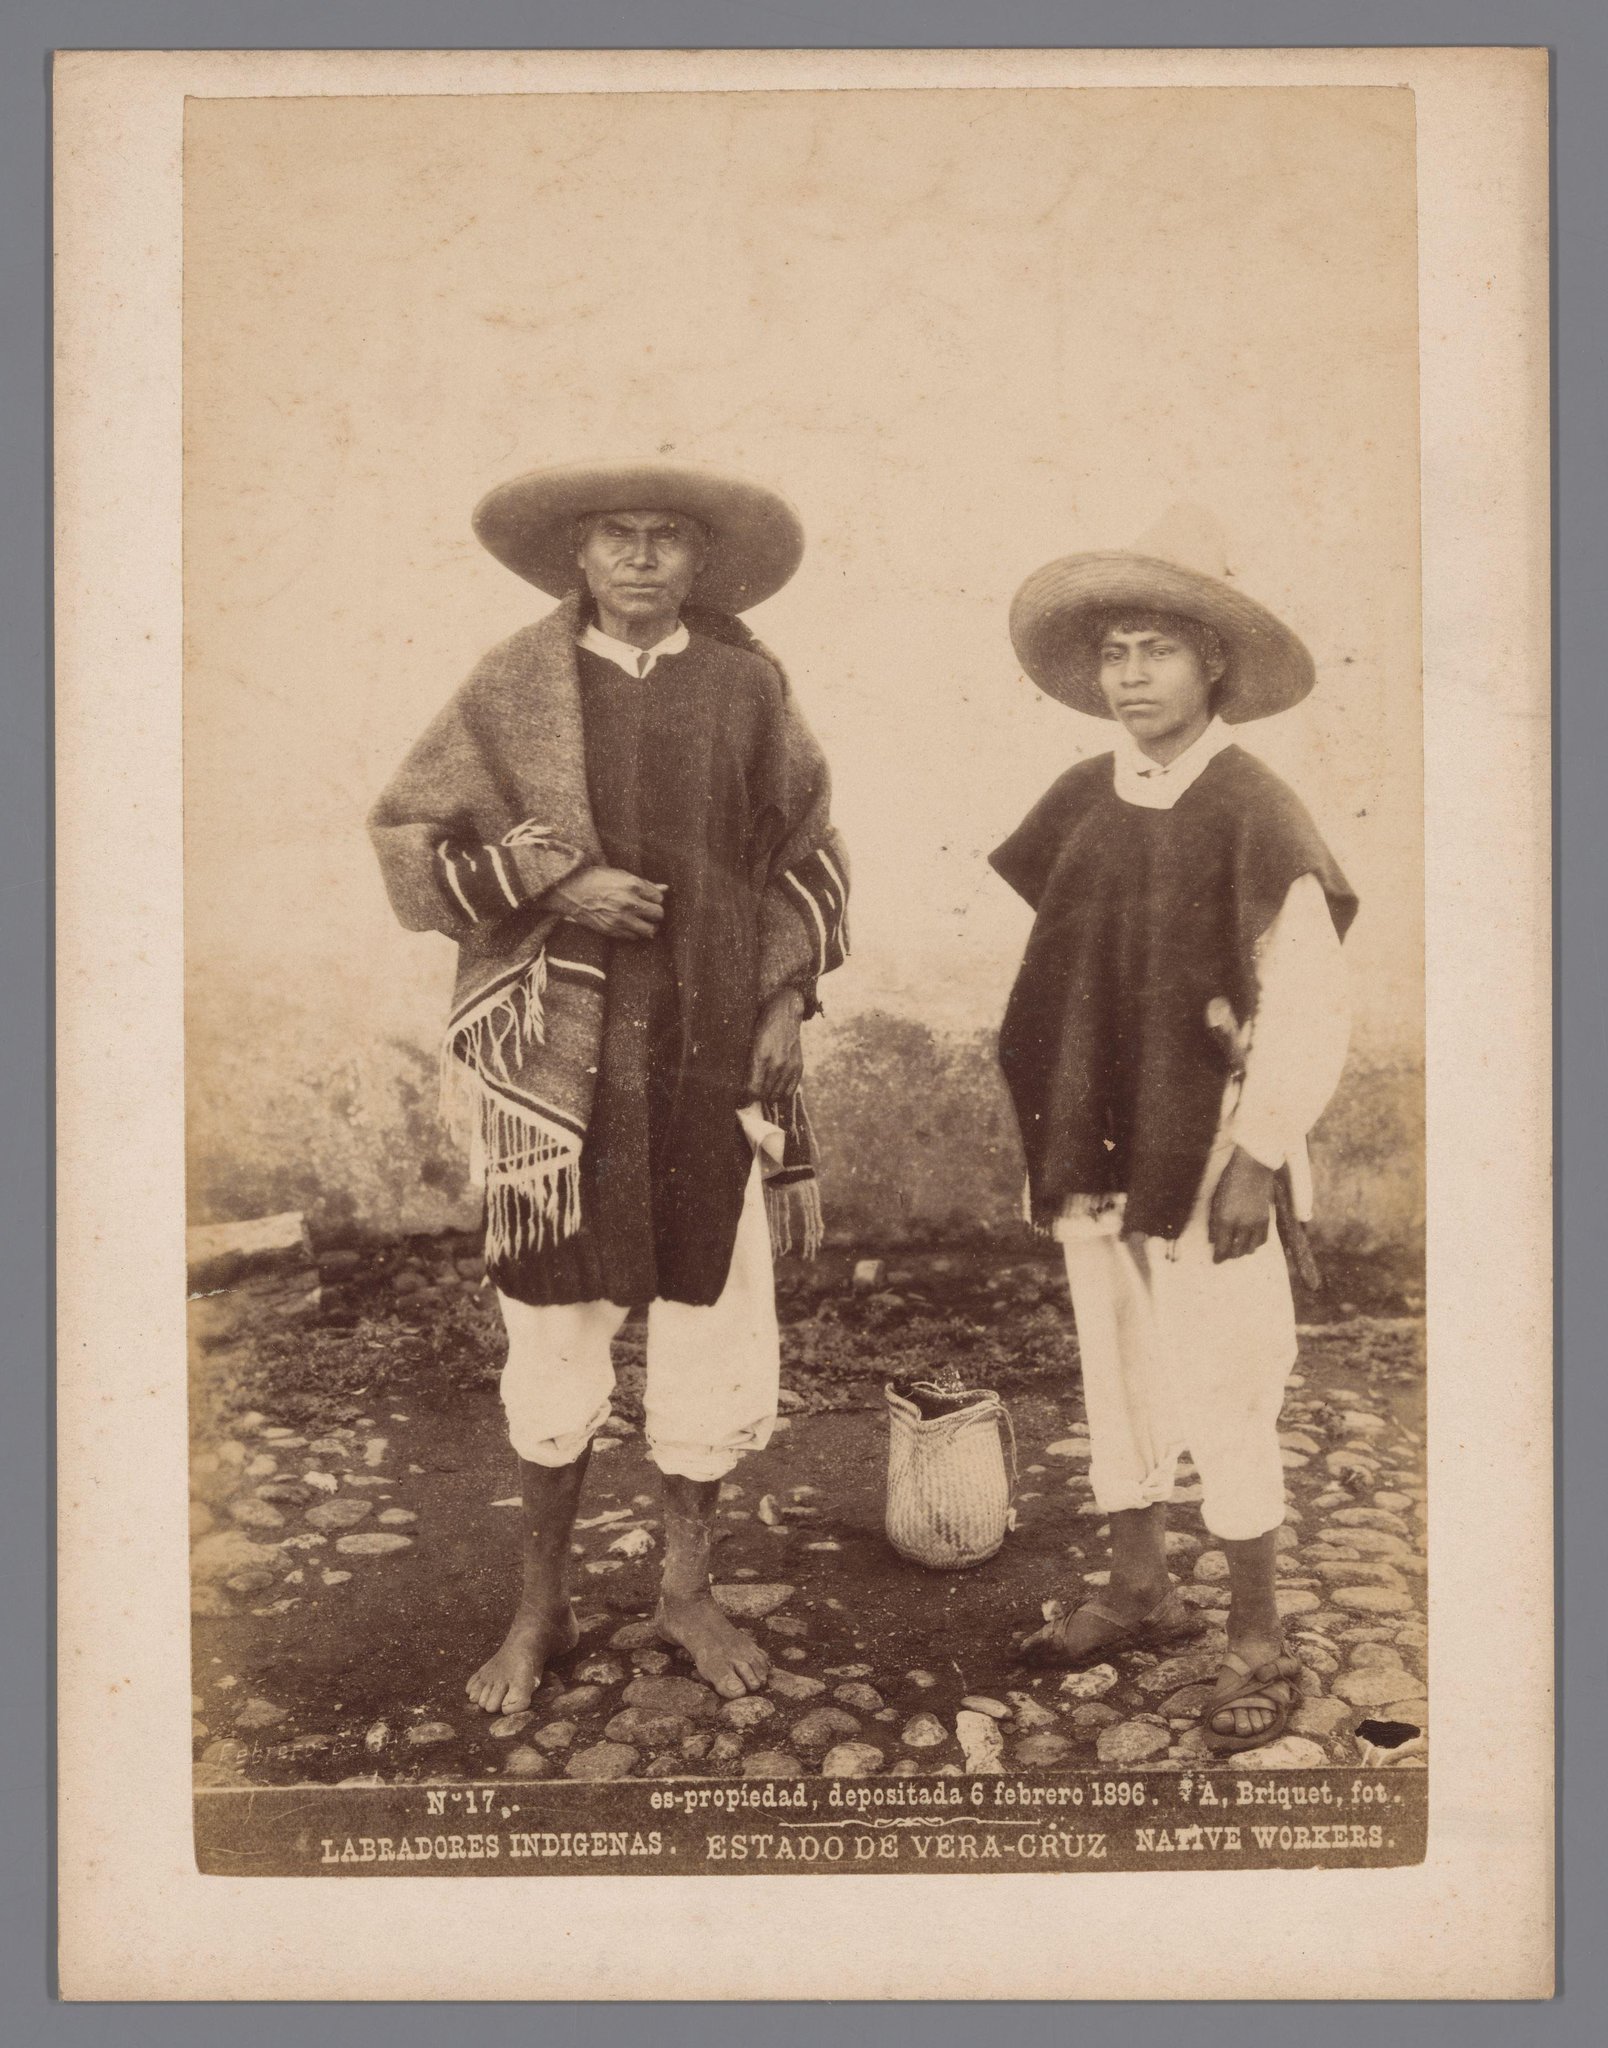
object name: photograph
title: Labradores Indigenas / Native workers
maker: abel briquet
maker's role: fotograaf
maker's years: 1833-1926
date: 1896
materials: cardboard, paper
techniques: albumen print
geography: veracruz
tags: adult man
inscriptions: number: ‘N. 17.’, copyright notice: ‘es-propriedad, depositada 6 febrero 1896.’